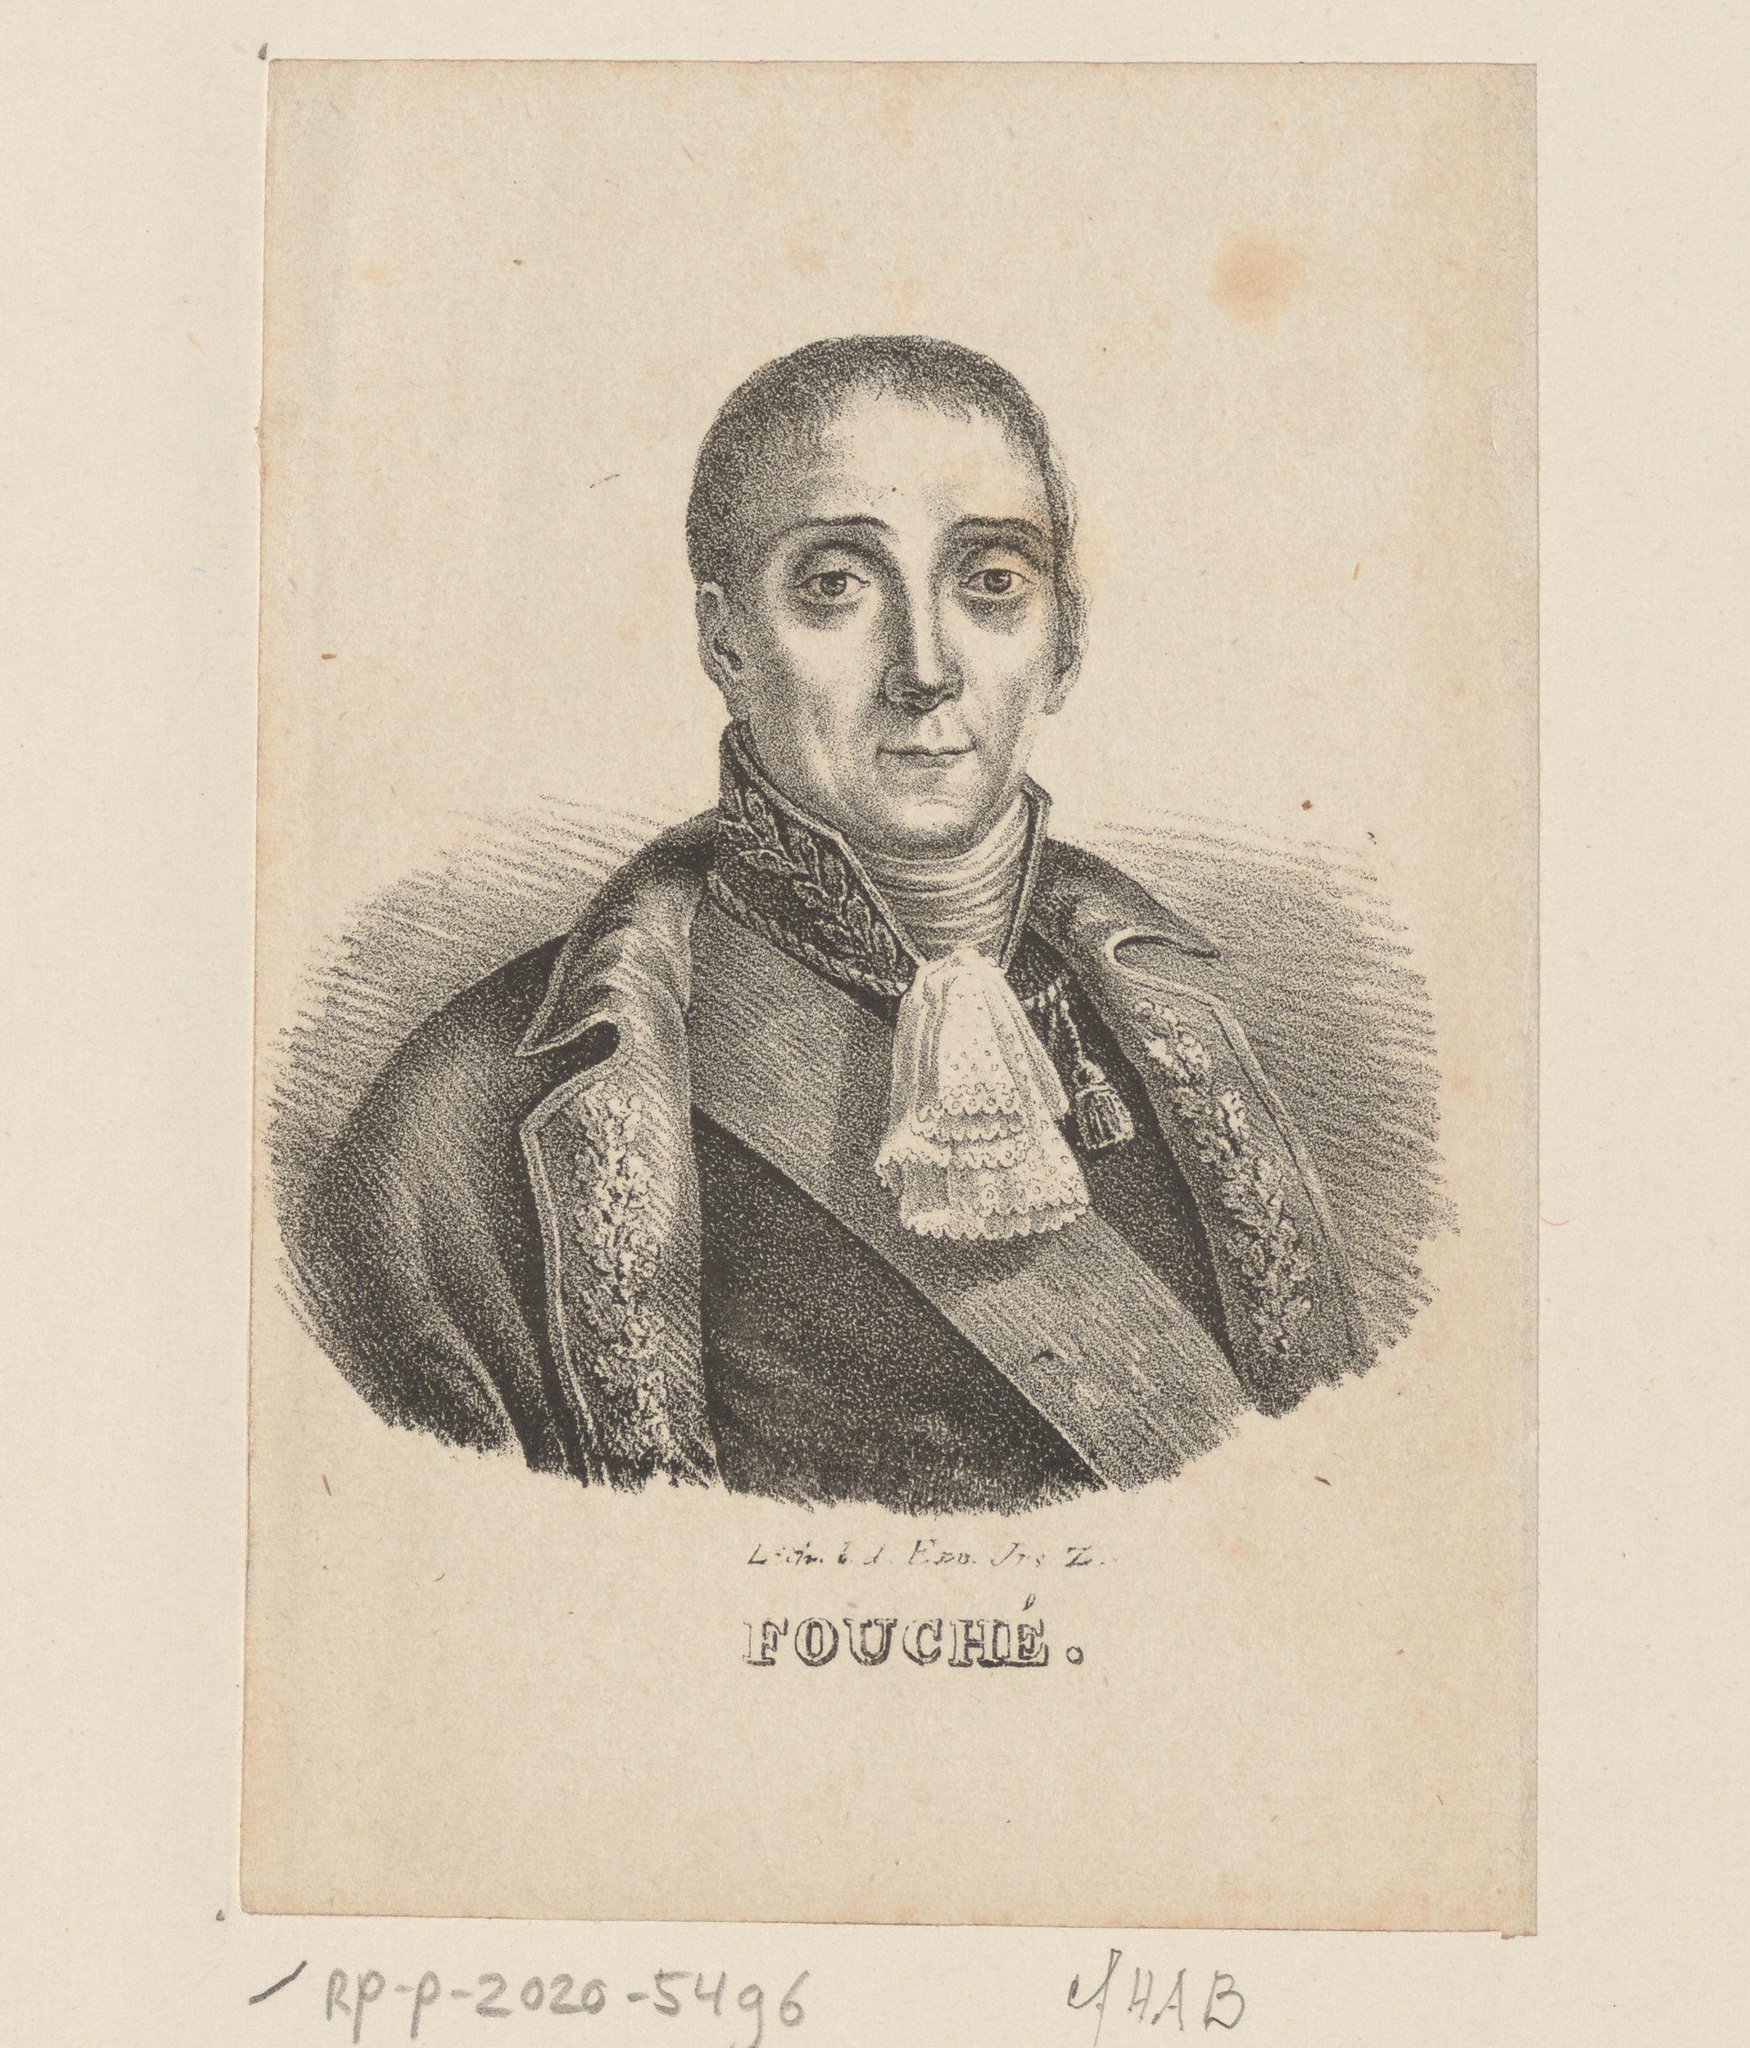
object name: print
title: Portret van Joseph Fouché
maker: Anonymous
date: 1800-1899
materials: paper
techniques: lithograph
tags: historical persons, politician, e.g. party leader